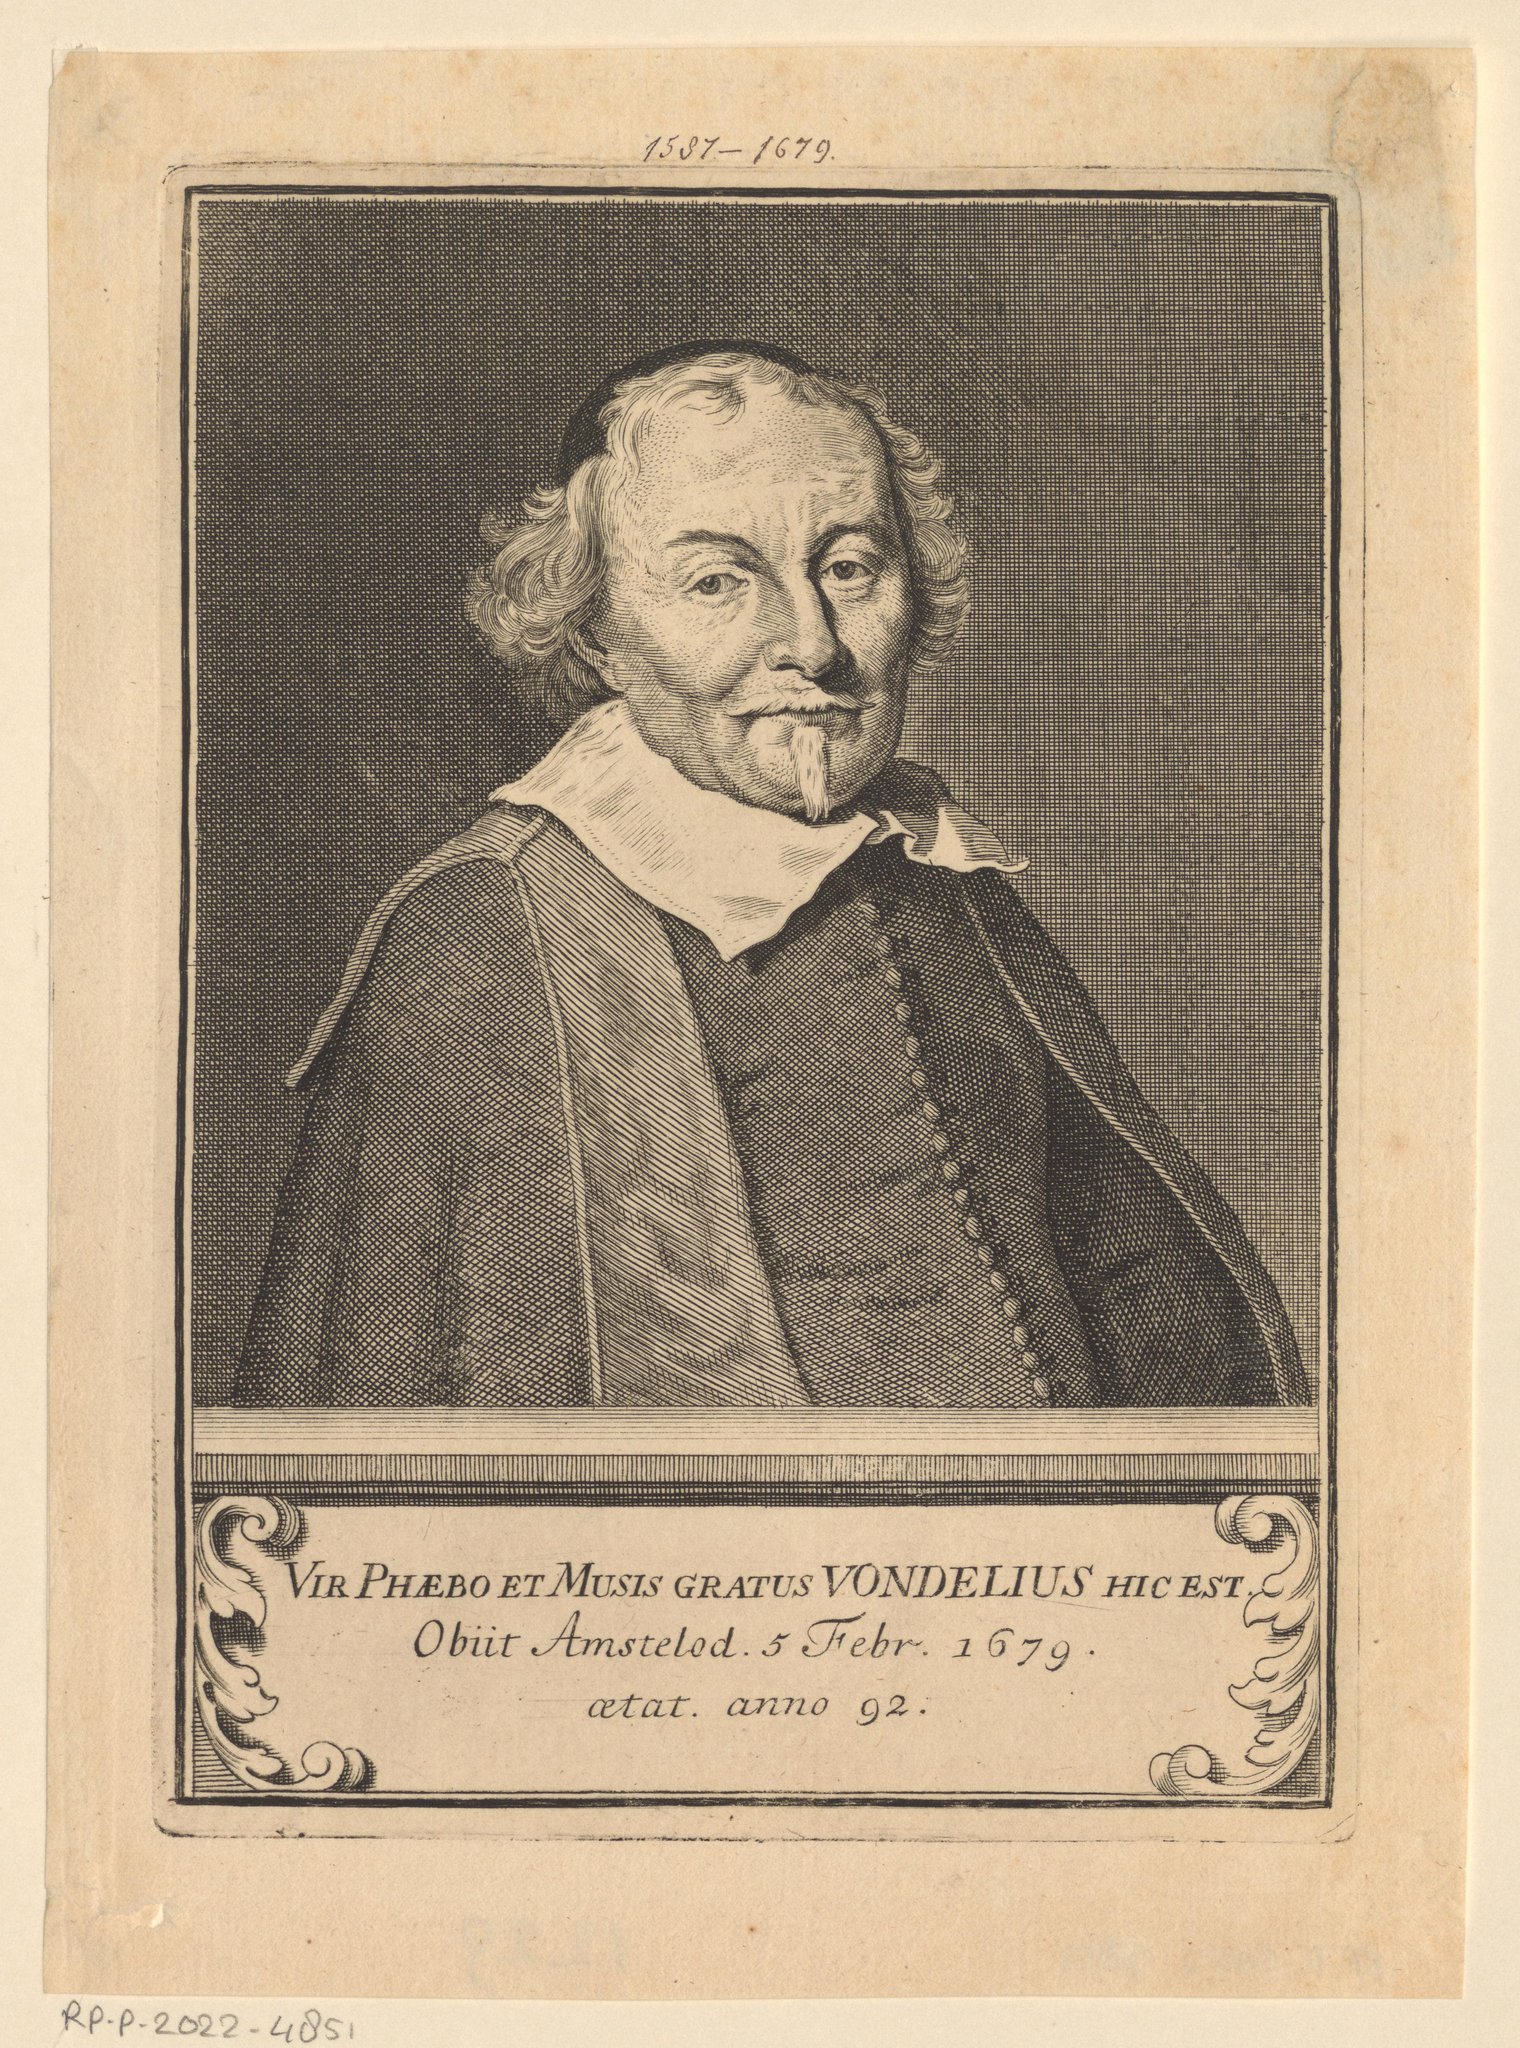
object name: print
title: Portret van Joost van den Vondel op 92-jarige leeftijd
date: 1739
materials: paper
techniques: engraving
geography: amsterdam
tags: cologne, amsterdam, joost van den vondel, historical persons, portrait of a writer, writer, poet, author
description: Prent waarschijnlijk uit: Foppens, Jean François. Bibliotheca belgica, sive virorum in Belgio vita scriptisque illustrium catalogus. Brussel: Petrum Foppens, 1739, dl. 2.